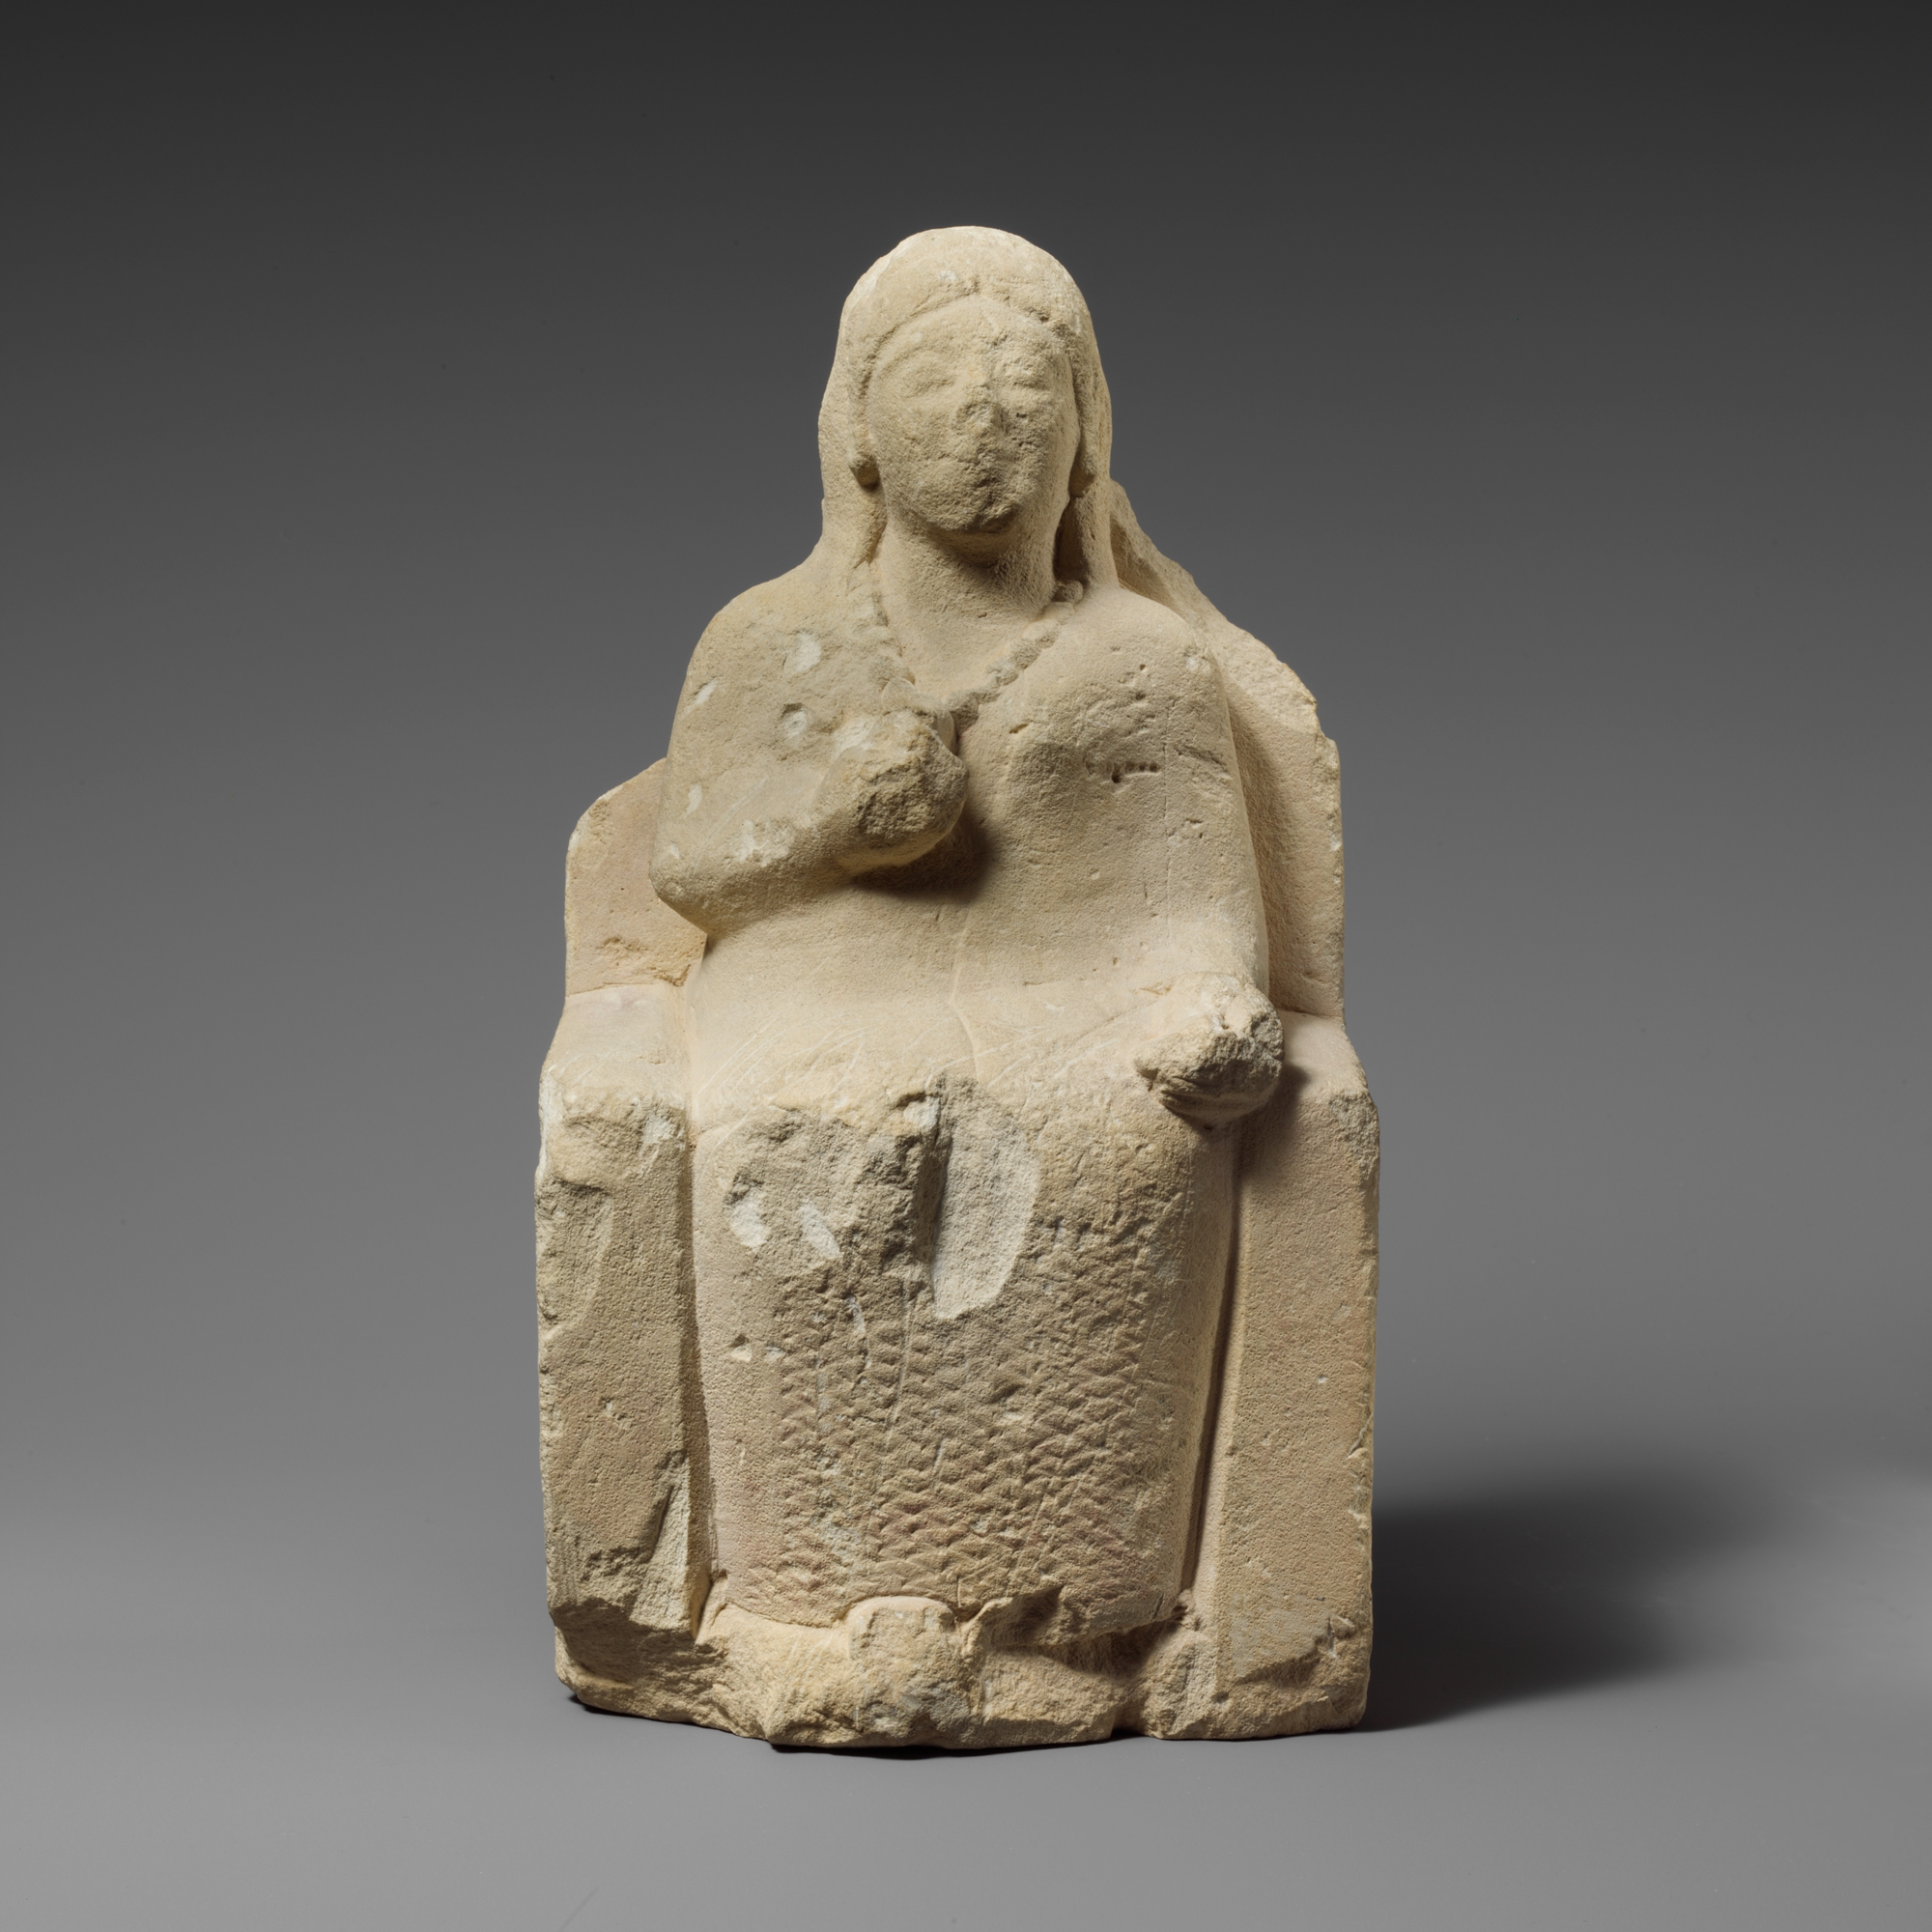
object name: statue of a female votary or deity, seated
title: Limestone statuette of a seated female votary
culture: cypriot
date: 534-501 BCE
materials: limestone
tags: women